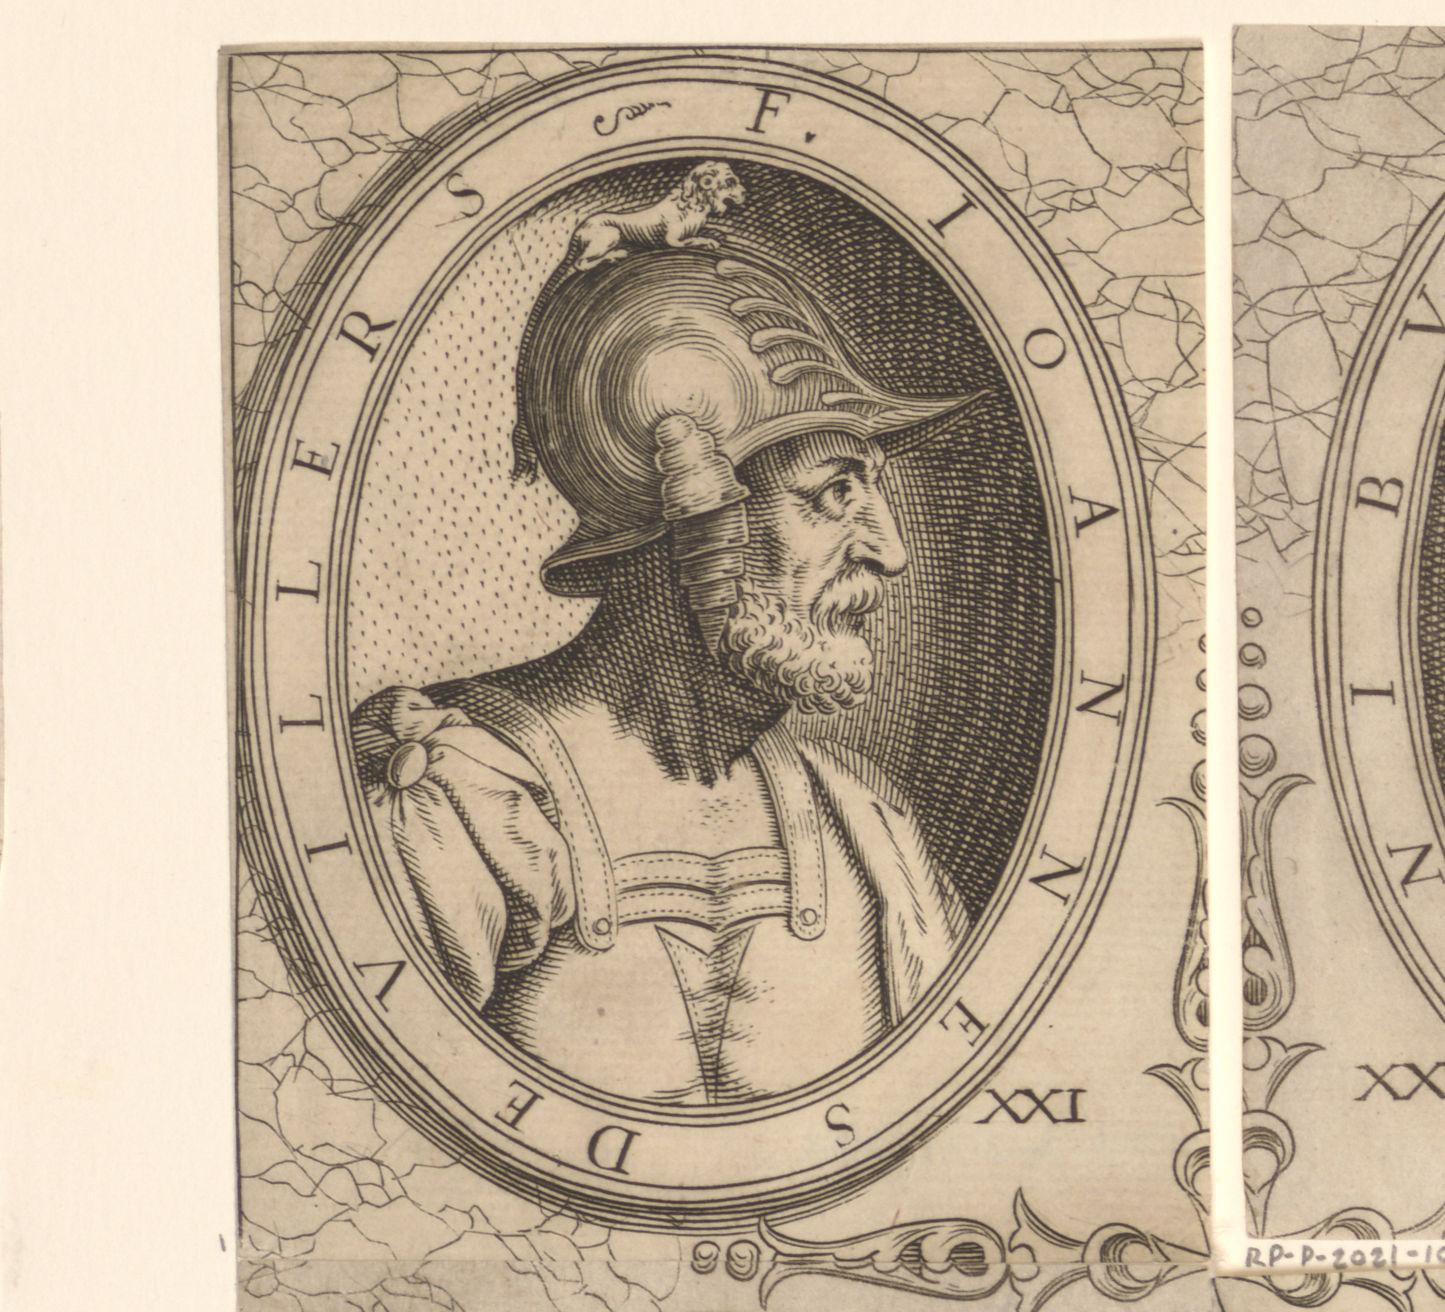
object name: print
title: Portret van Jean de Villiers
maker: philippe thomassin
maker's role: print maker, publisher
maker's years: 1562-1622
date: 1588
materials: paper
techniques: engraving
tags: historical persons, military orders, e.g.: knights templars, knights of malta, teutonic knights ~ roman catholic church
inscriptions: collector's mark: Lugt 2228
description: Deze prent maakt deel uit van een grotere prent met vier portretten die later is verknipt. Prent waarschijnlijk uit: Veltroni, Tolomeo. Statuta hospitalis Hierusalem. [Rome: s.n., 1588].